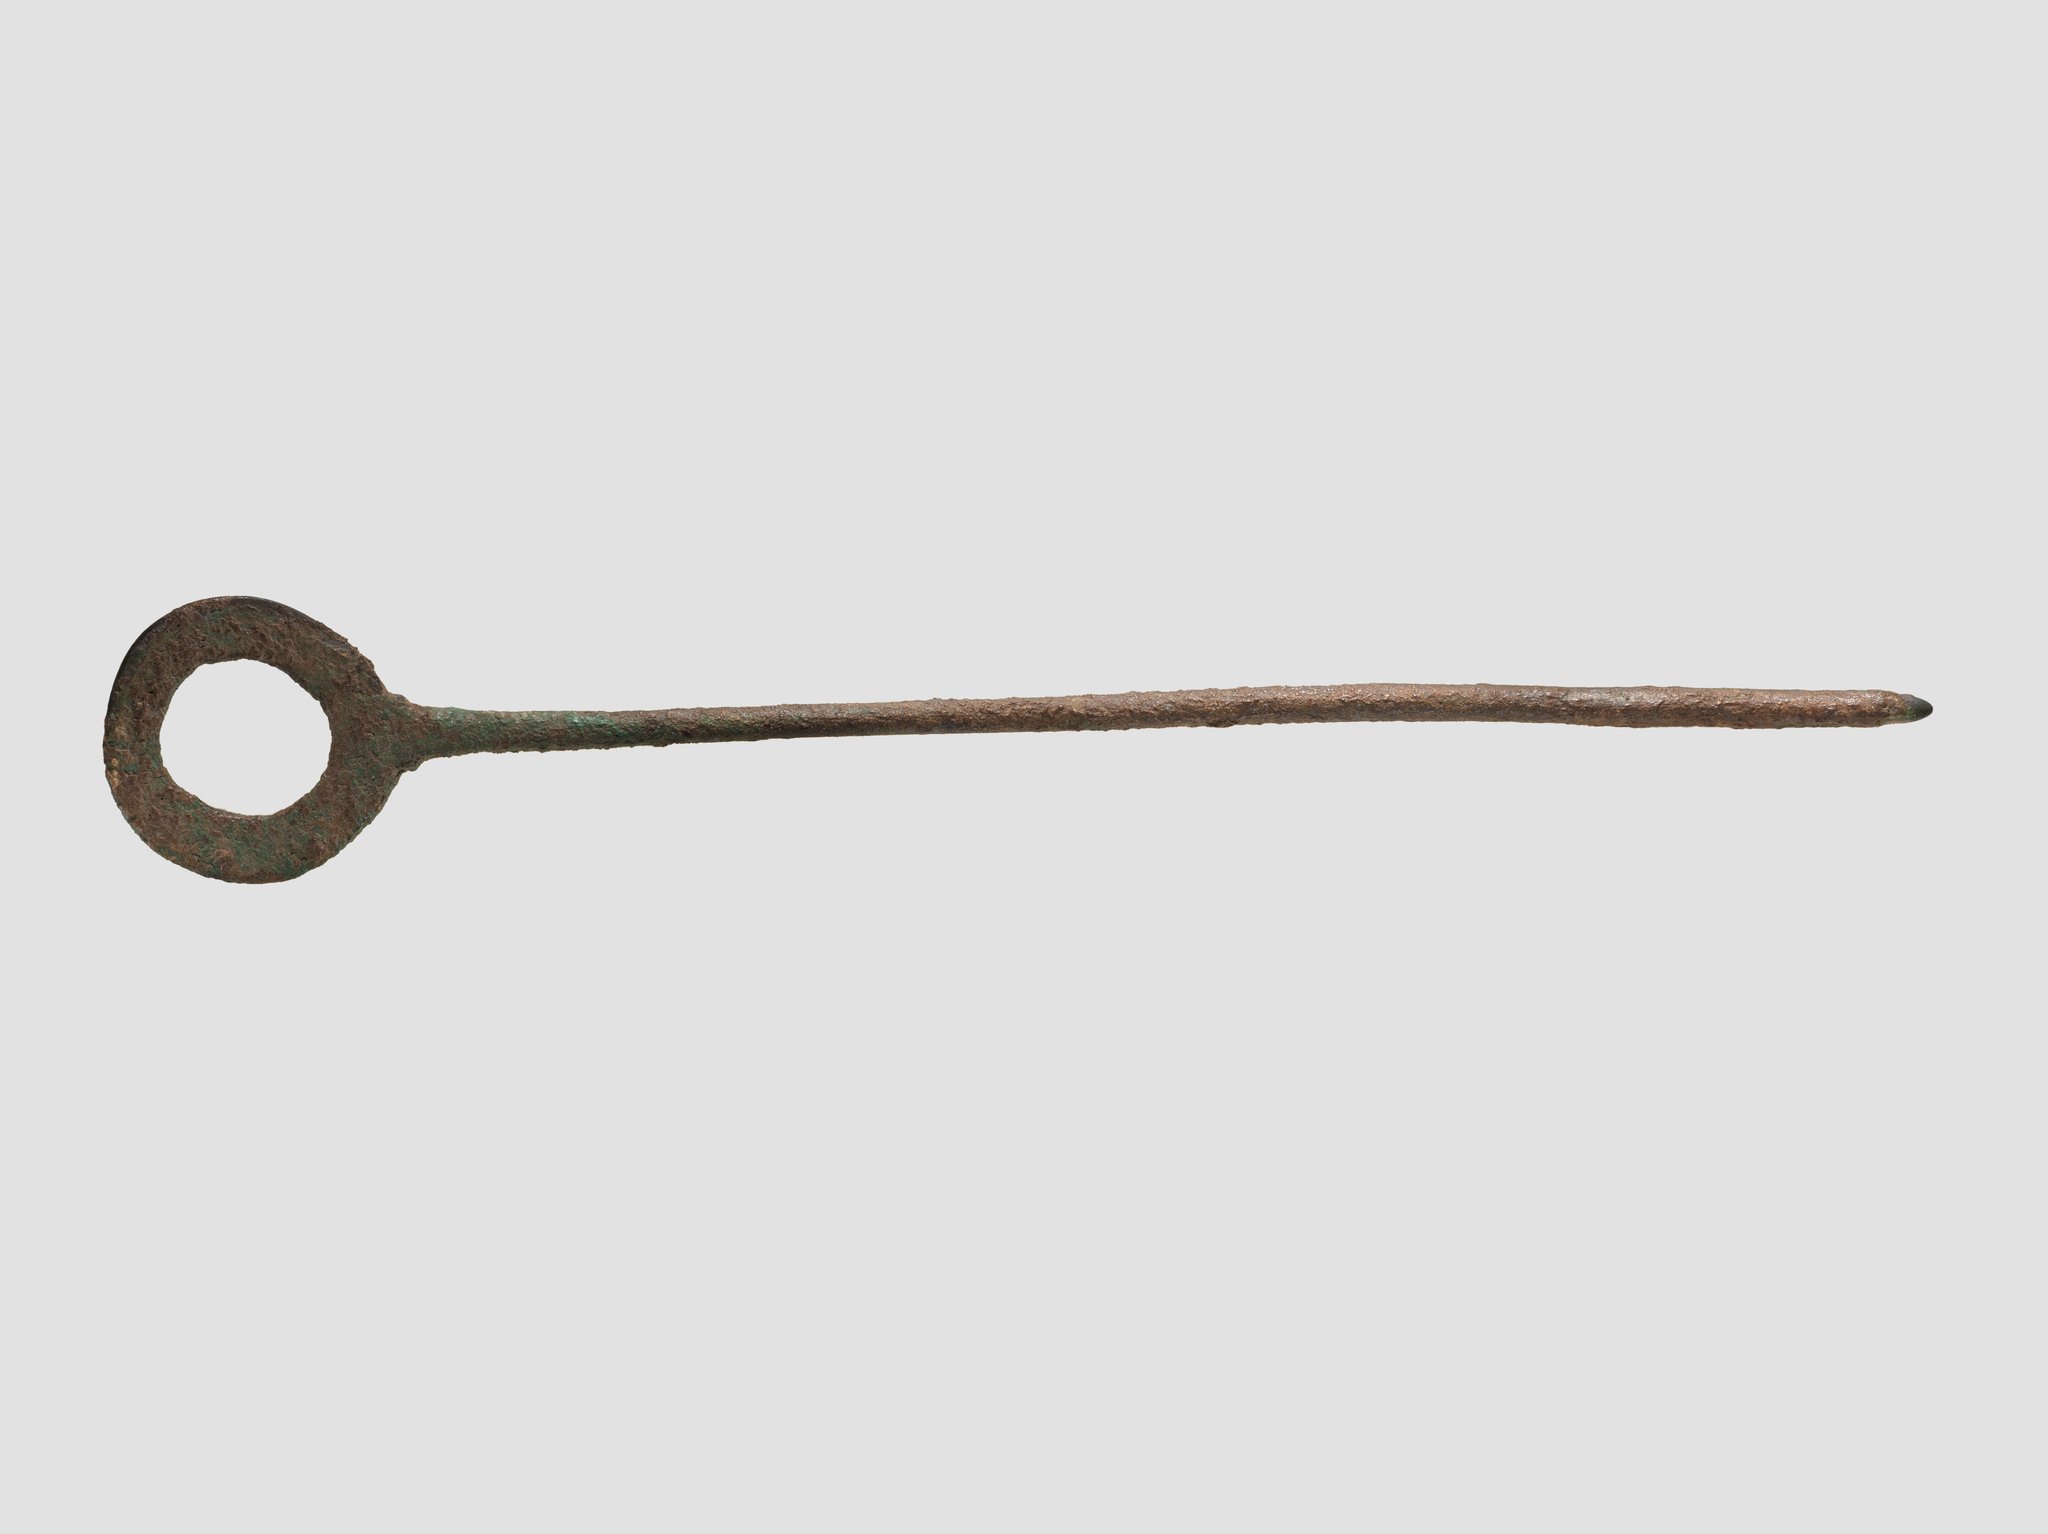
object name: pin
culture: sasanian or islamic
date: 401-700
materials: copper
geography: iran